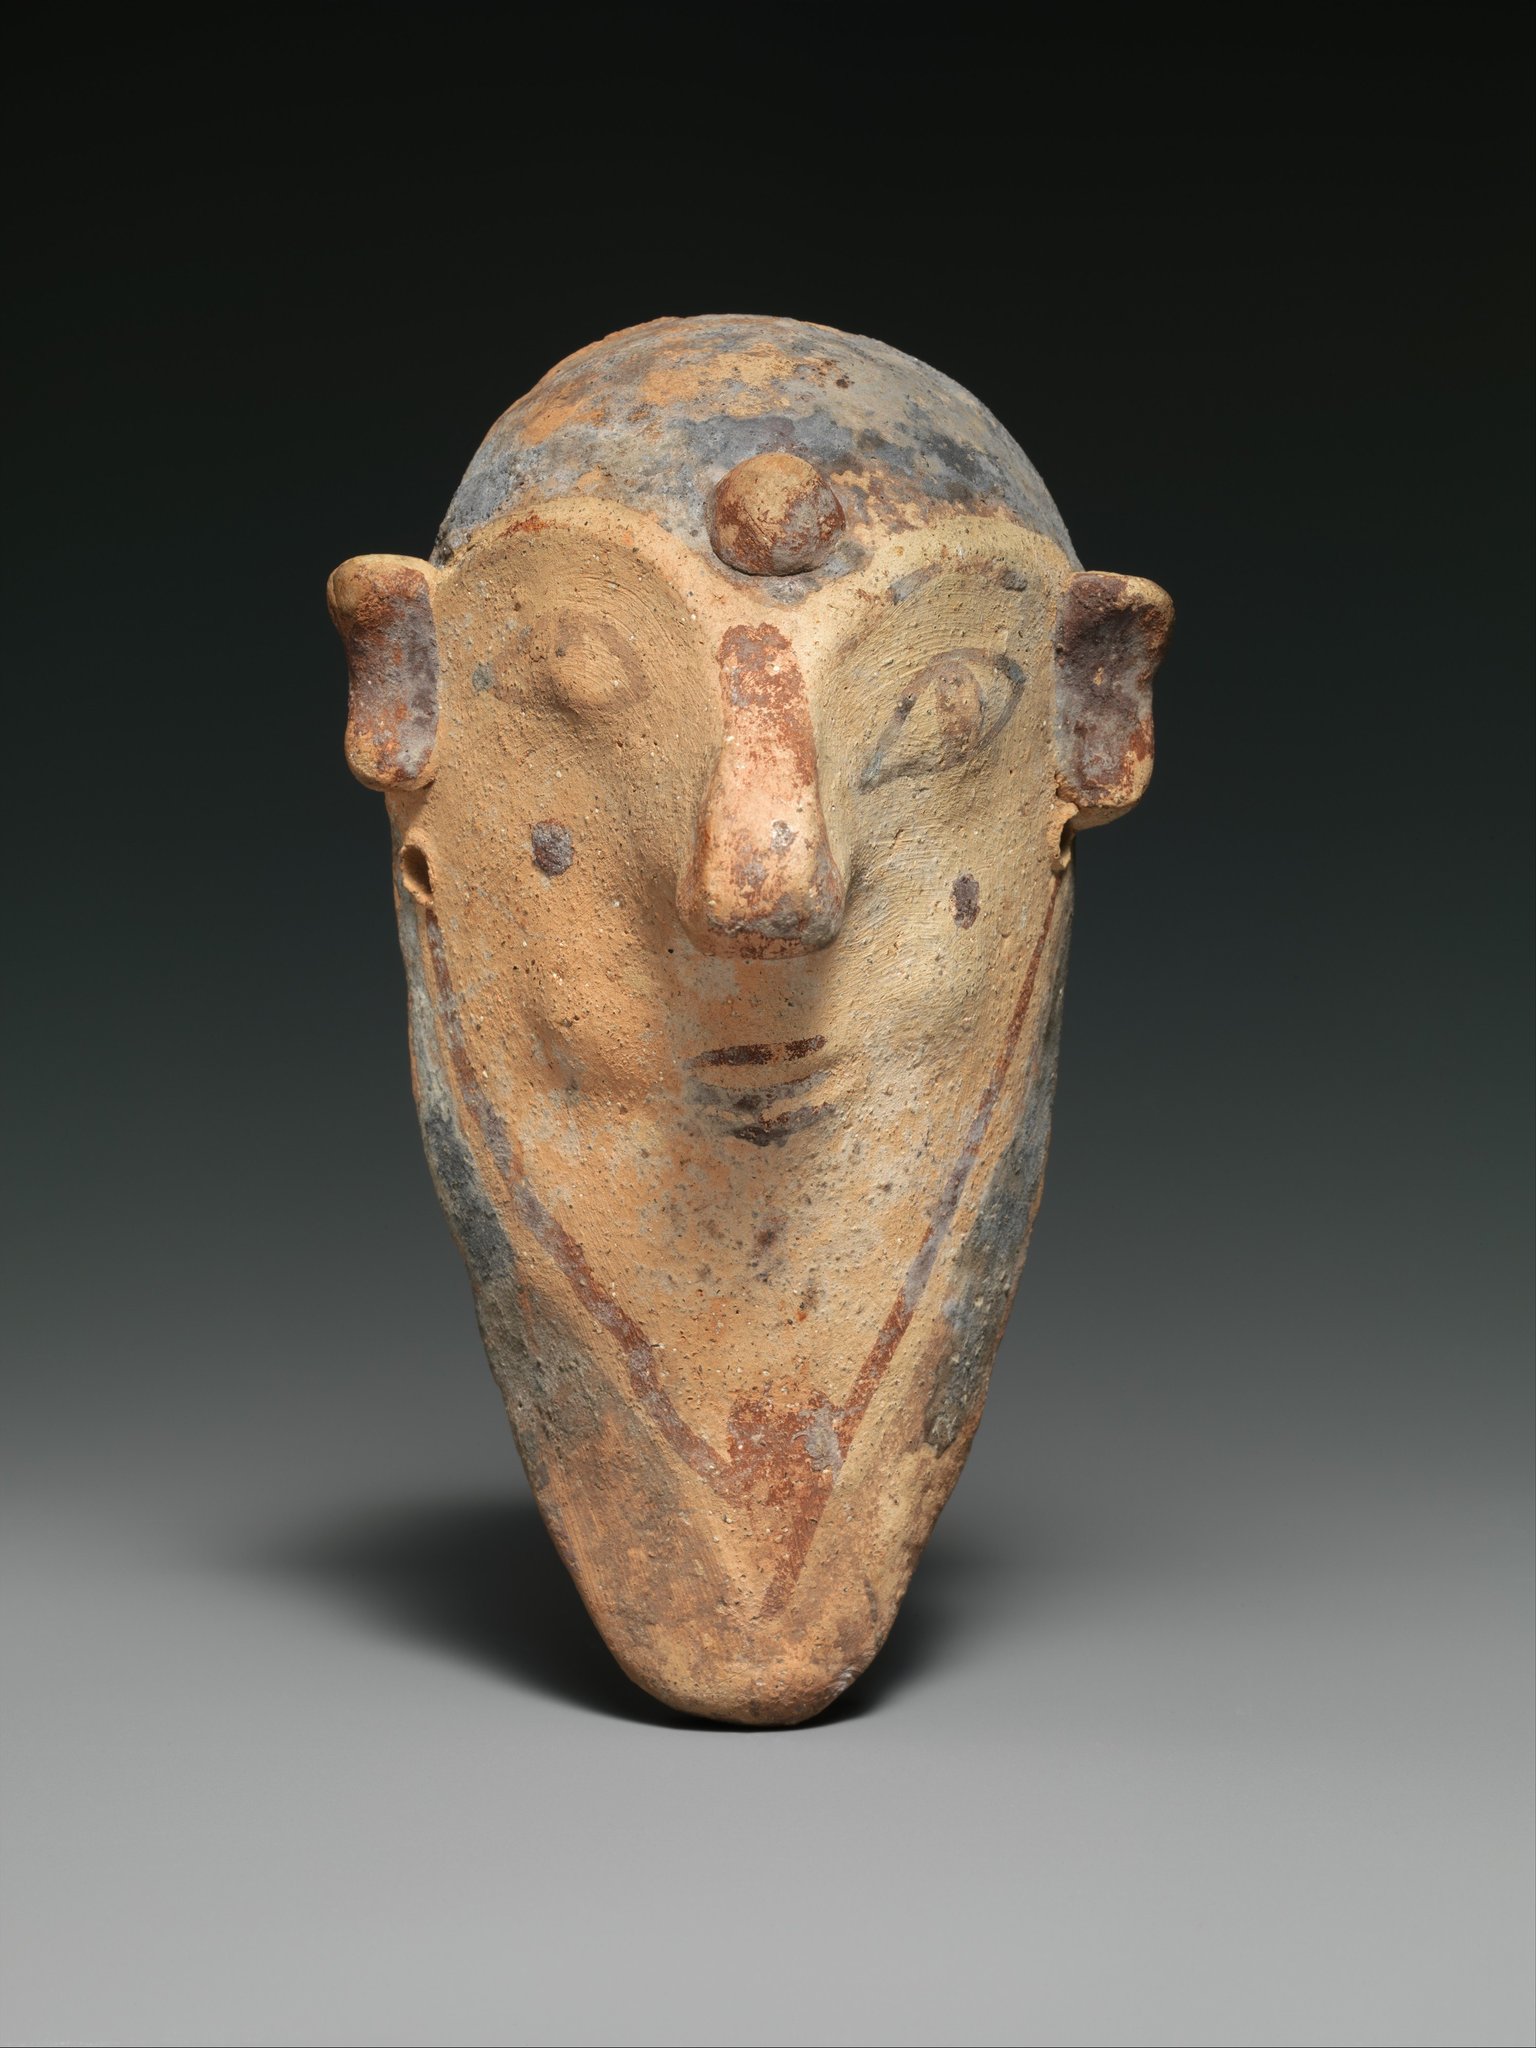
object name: mask of a bearded male head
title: Terracotta mask of a bearded man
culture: cypriot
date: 600-480 BCE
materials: terracotta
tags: masks